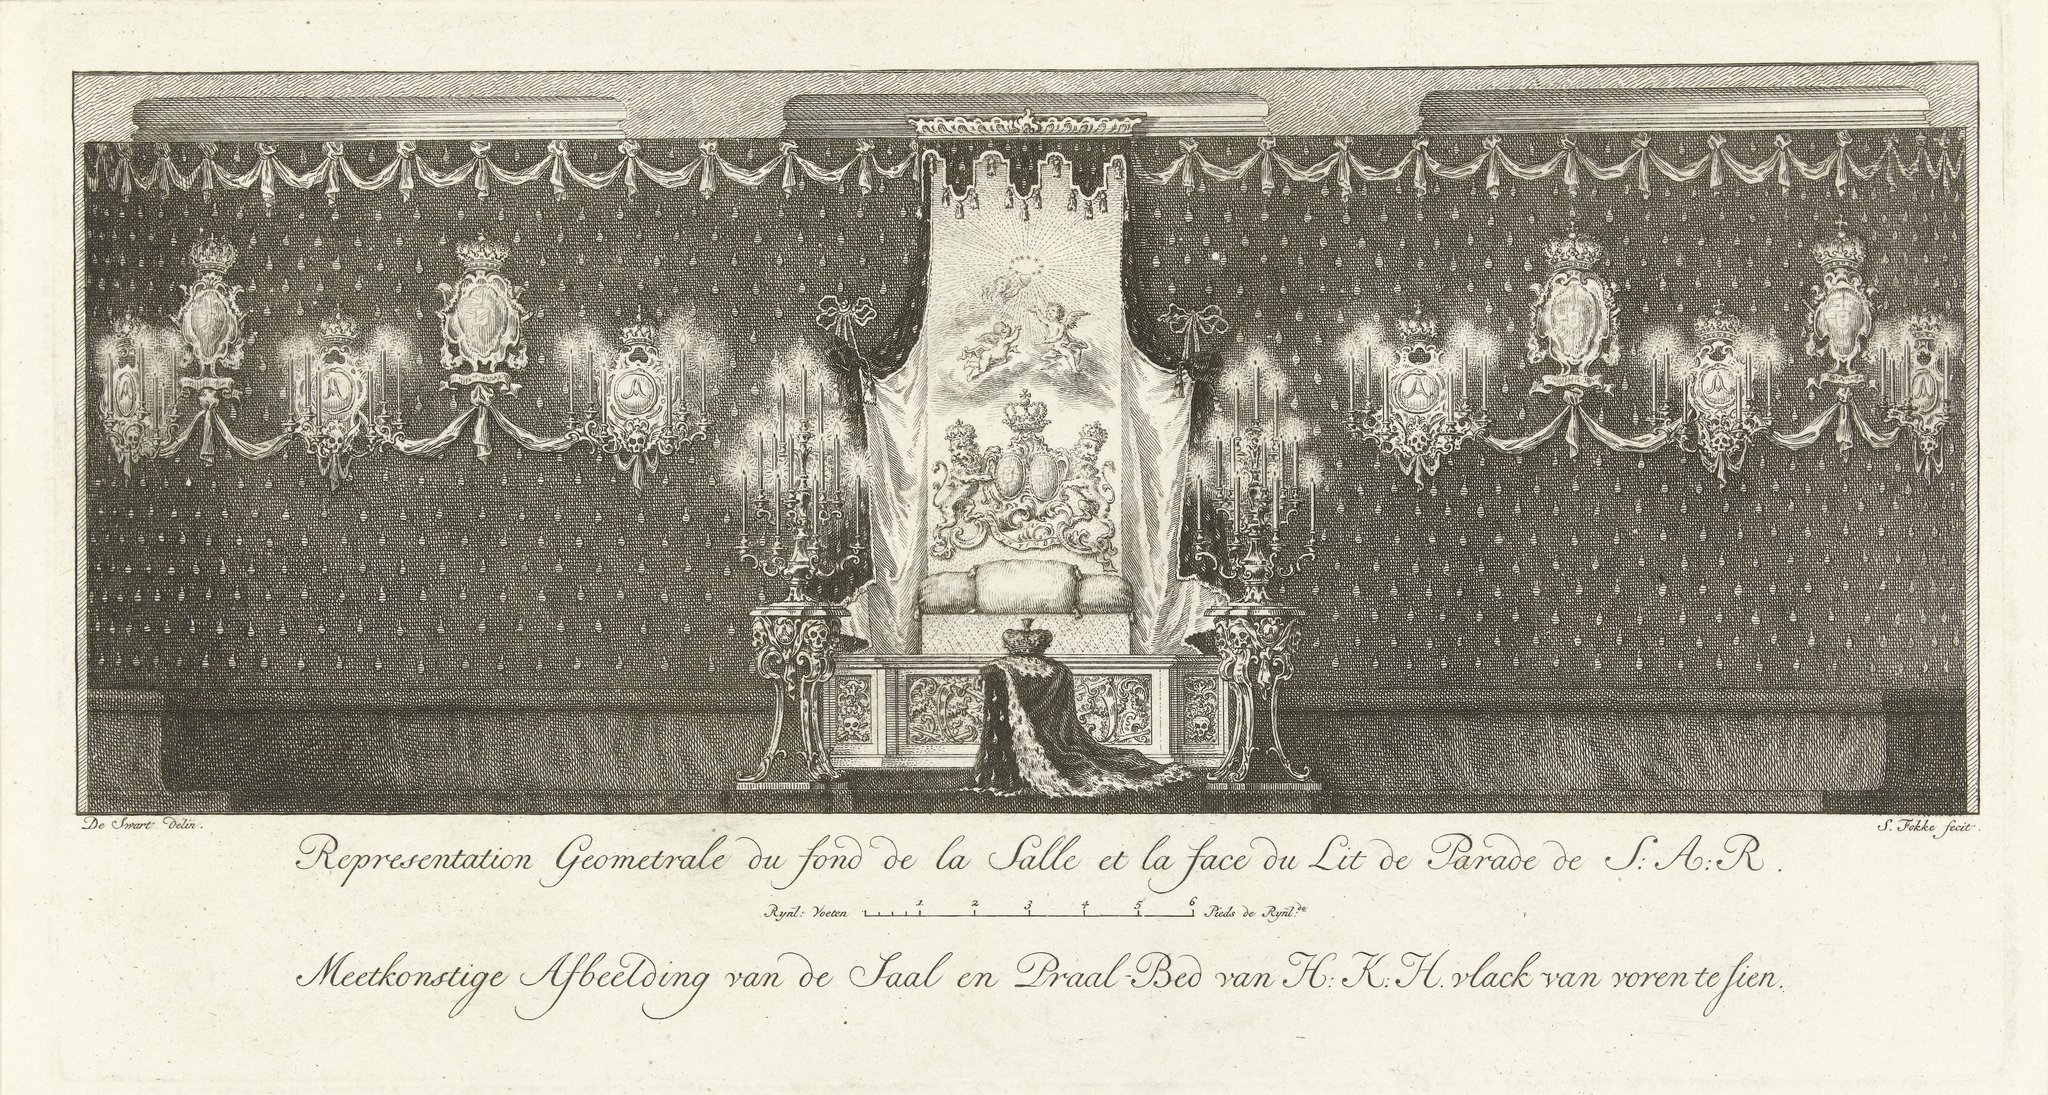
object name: print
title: Paradezaal en praalbed voor prinses Anna, 1759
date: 1759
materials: paper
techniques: engraving, etching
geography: northern netherlands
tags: the hague, anna van hannover, lying in state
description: Paradezaal met vooraanzicht van het praalbed voor de prinses. Voor het bed de koninklijke mantel en kroon op een voetstuk. Onderdeel van een serie van vier platen van het praalbed waarop de op 12 januari 1759 overleden prinses Anna van Hannover gedurende enkele dagen in februari opgebaard heeft gelegen.